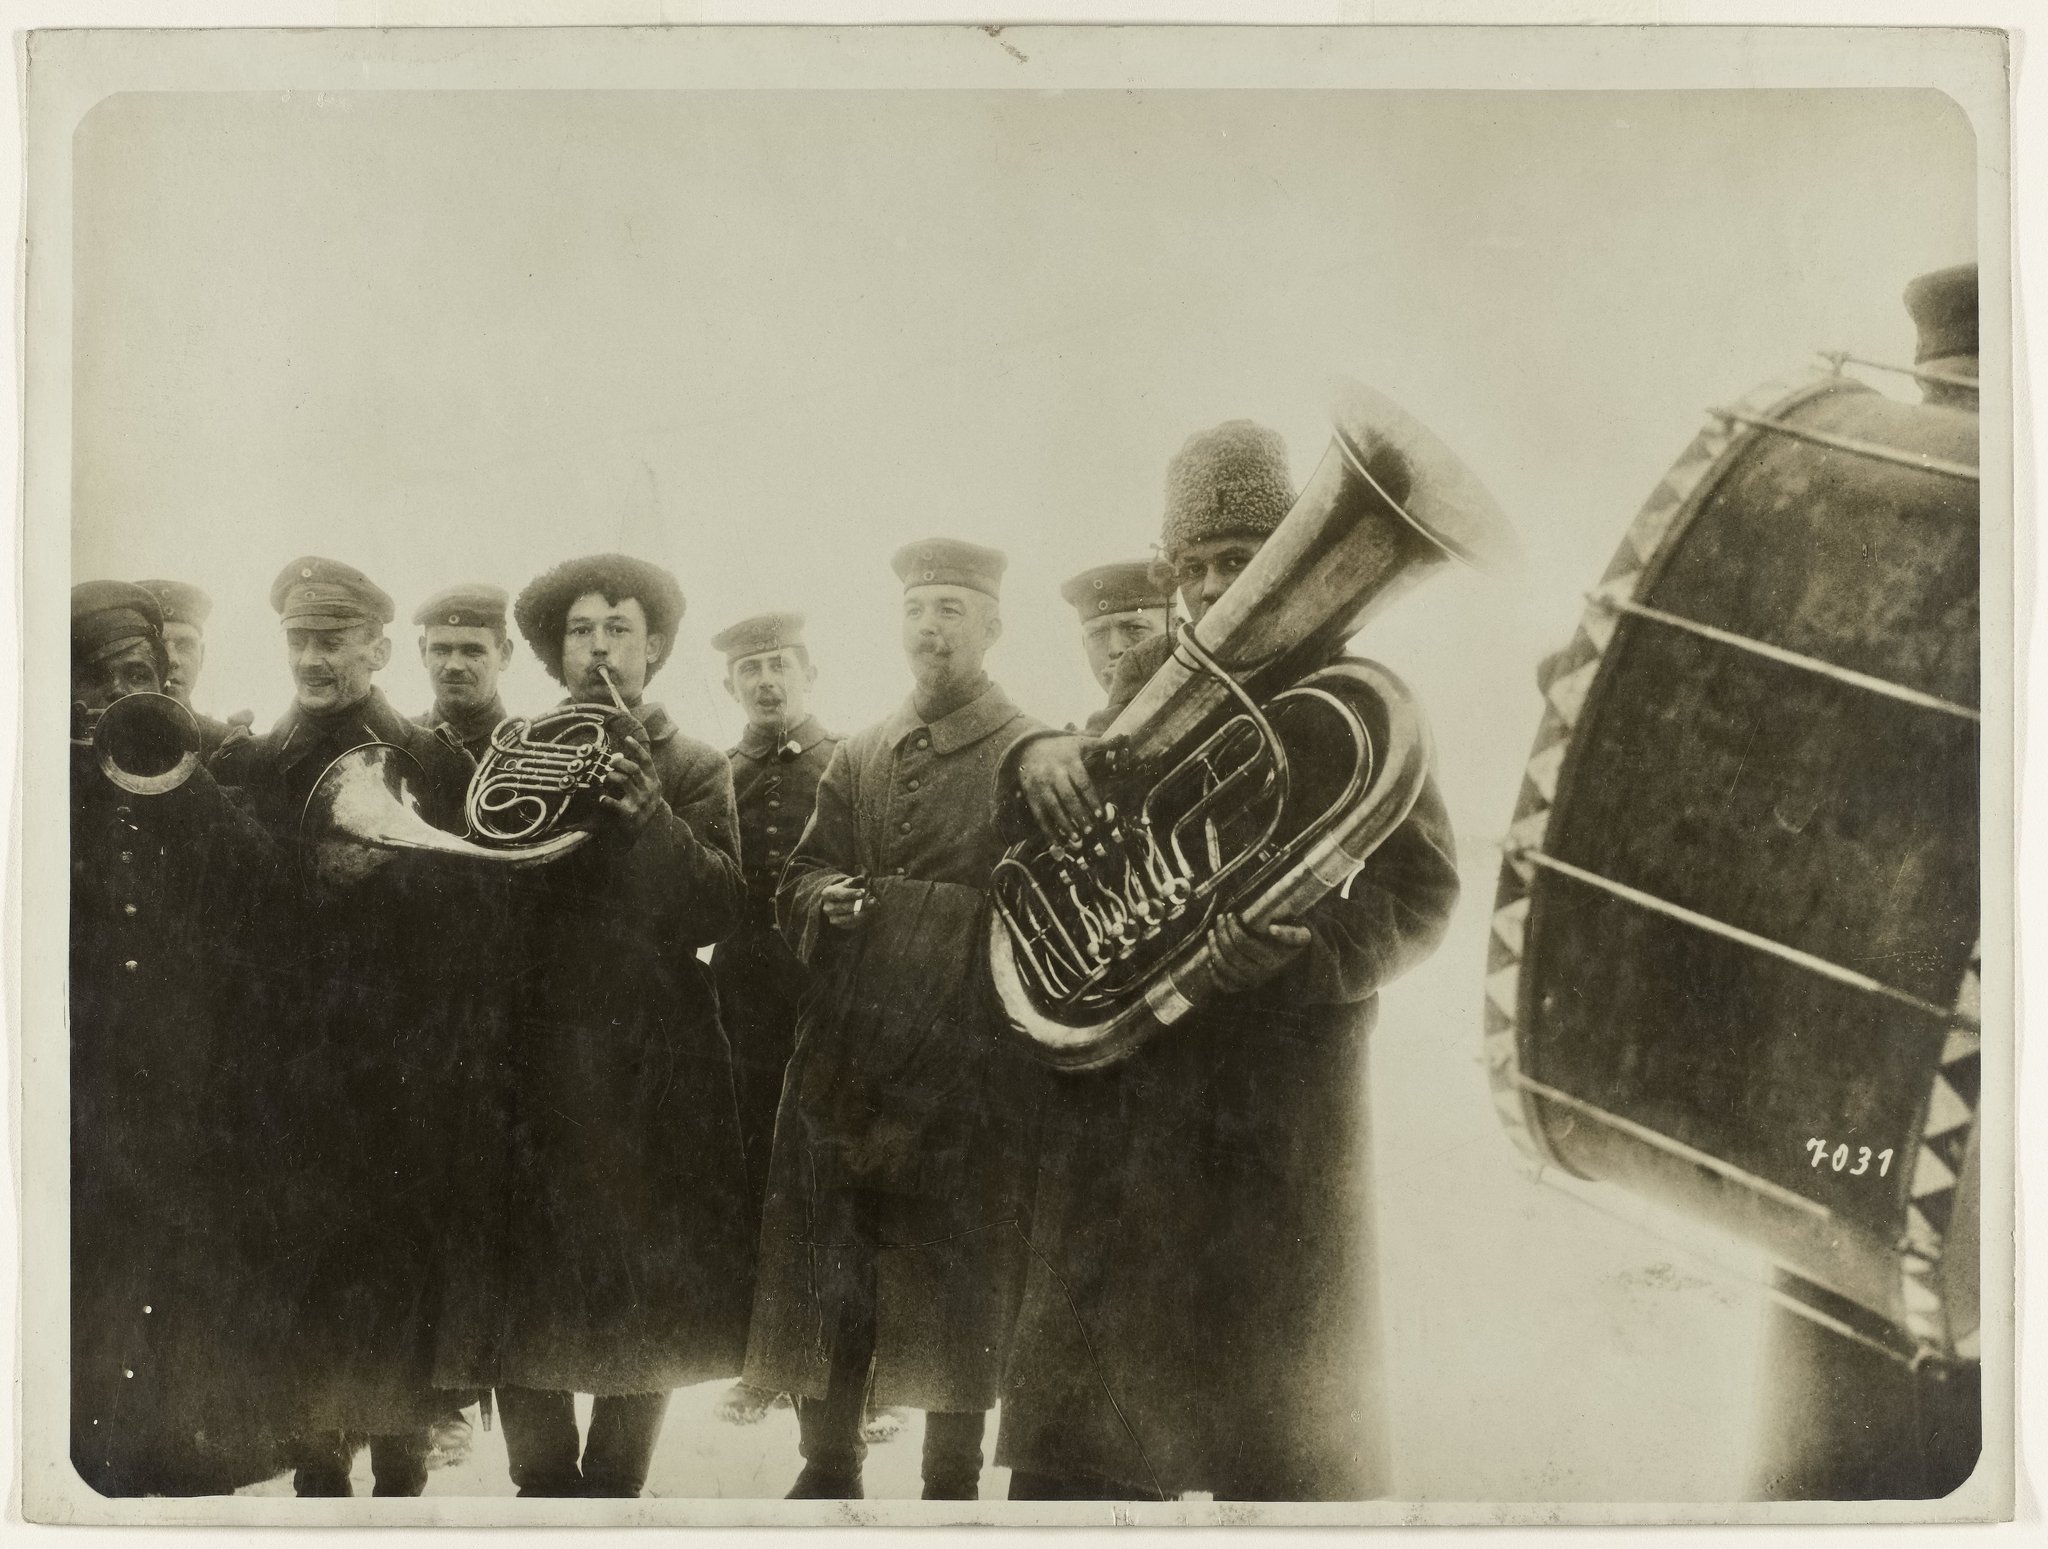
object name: photograph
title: Muziekkorps van Duitse militairen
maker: Anonymous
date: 1914-1918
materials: paper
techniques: gelatin silver print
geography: germany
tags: military band, germany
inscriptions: number: ‘7031’